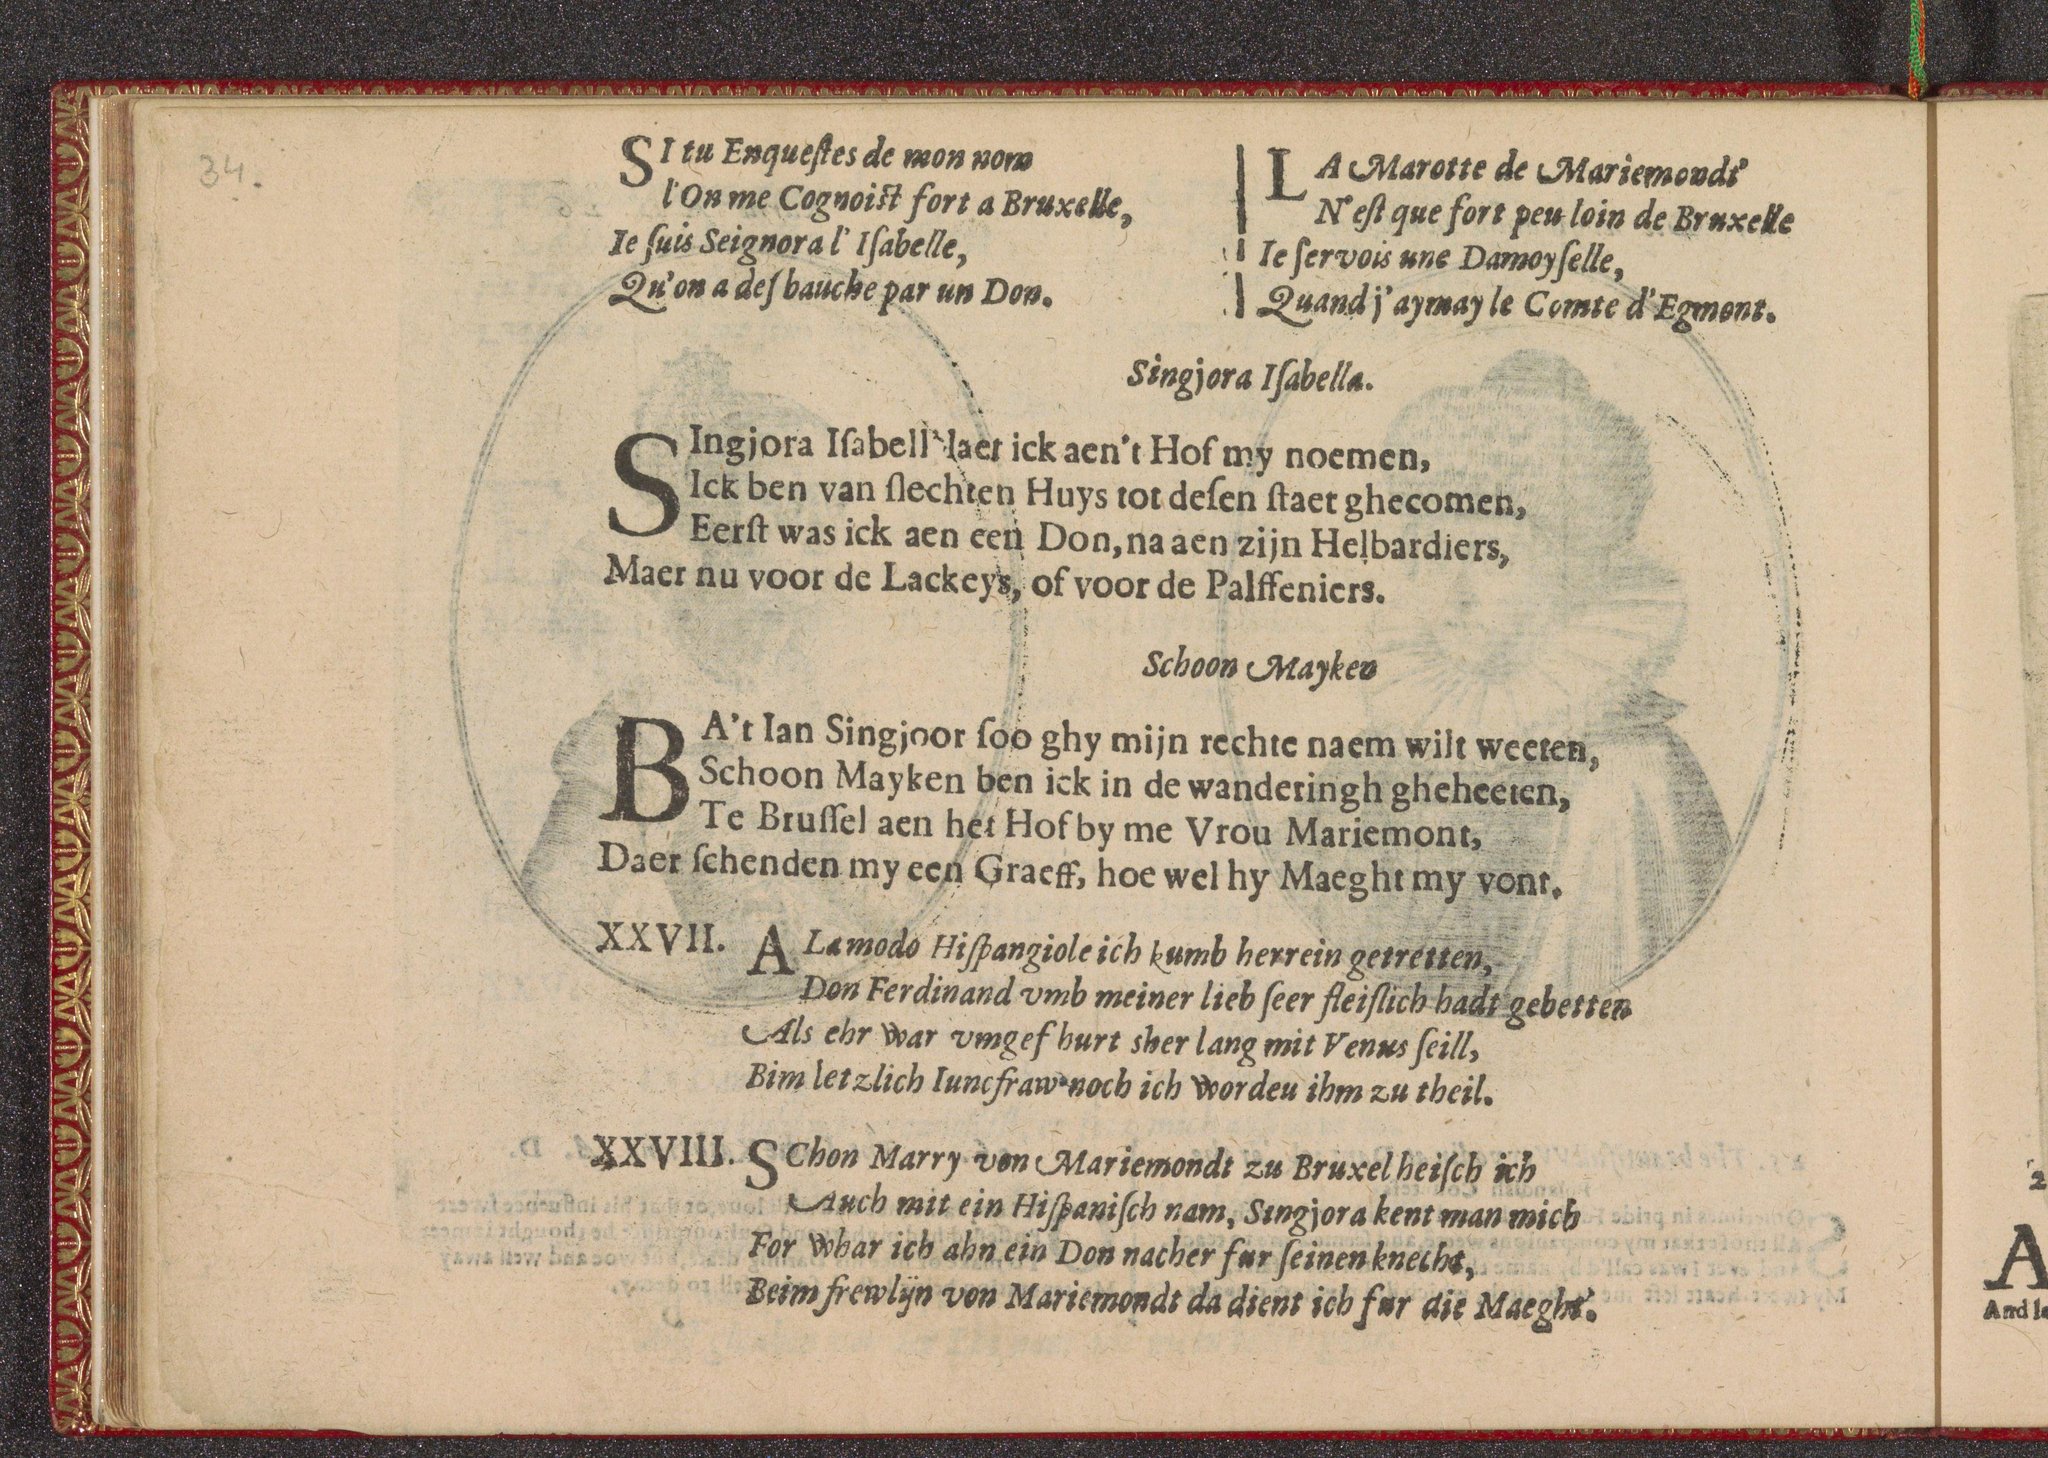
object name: text sheet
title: Miroir des plus belles courtisanes de ce temps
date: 1635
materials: paper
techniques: letterpress printing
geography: utrecht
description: Drie keer twee kwatrijnen in het Frans, Nederlands en Duits bij de portretten van de courtisanes genaamd Signora Isabella en Schone Mayken (Maria), beiden afkomstig uit Brussel. Het blad maakt deel uit van een album.